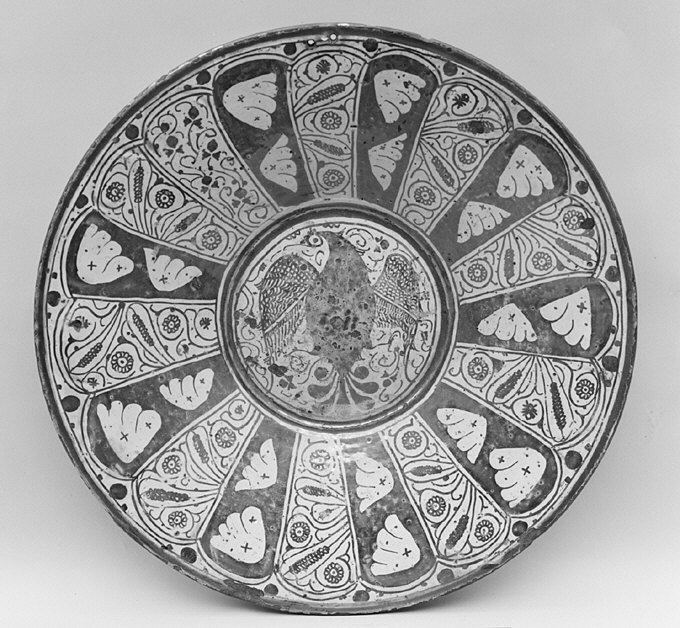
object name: dish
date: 1576-1600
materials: earthenware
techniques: luster painting, glazing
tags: birds